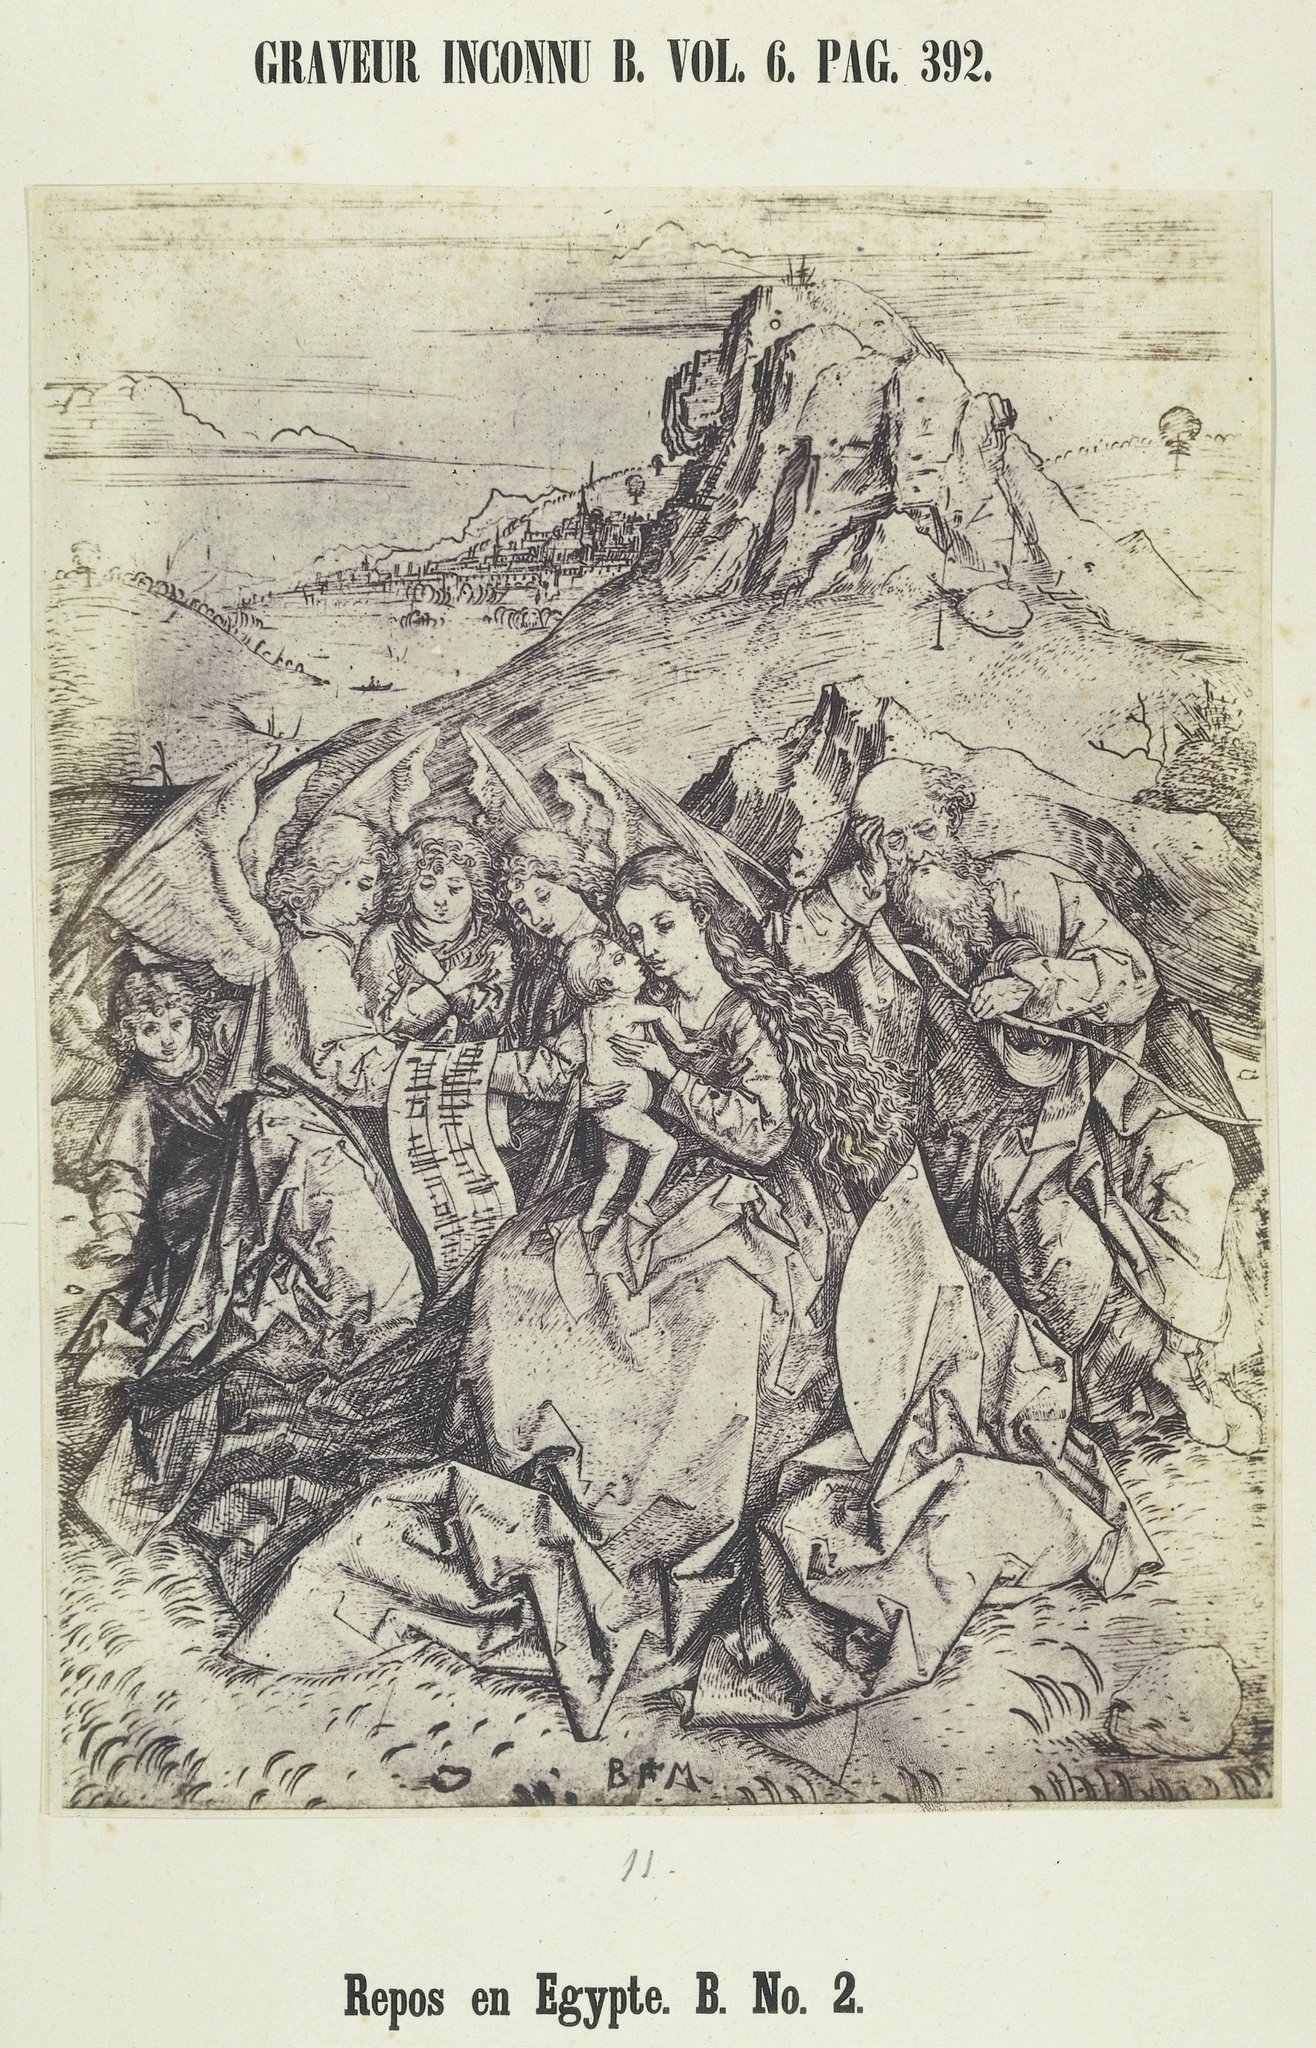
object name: photograph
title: Fotoreproductie van een gravure door de monogrammist BM, 'Rust op de vlucht naar Egypte'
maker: alois löcherer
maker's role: fotograaf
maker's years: 1815-1862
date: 1854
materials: cardboard, paper, photographic support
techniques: salted paper print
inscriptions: inscription: ‘11.’, caption: ‘Repos en Egypte. B. No. 2’, inscription: ‘GRAVEUR INCONNU B. VOL. 6. PAG. 392.’